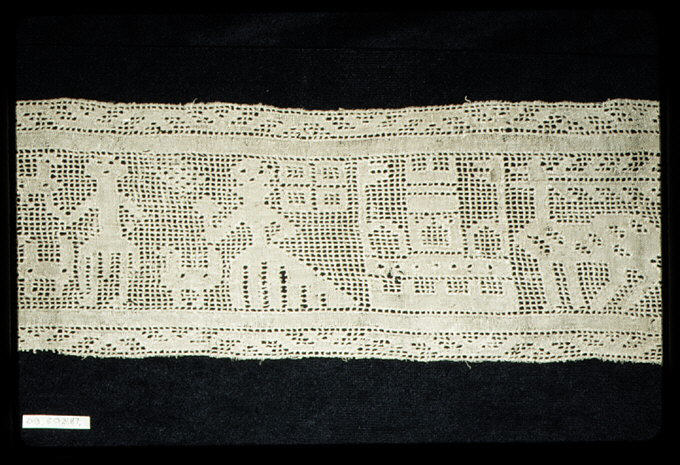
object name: band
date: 1601-1800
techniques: embroidery